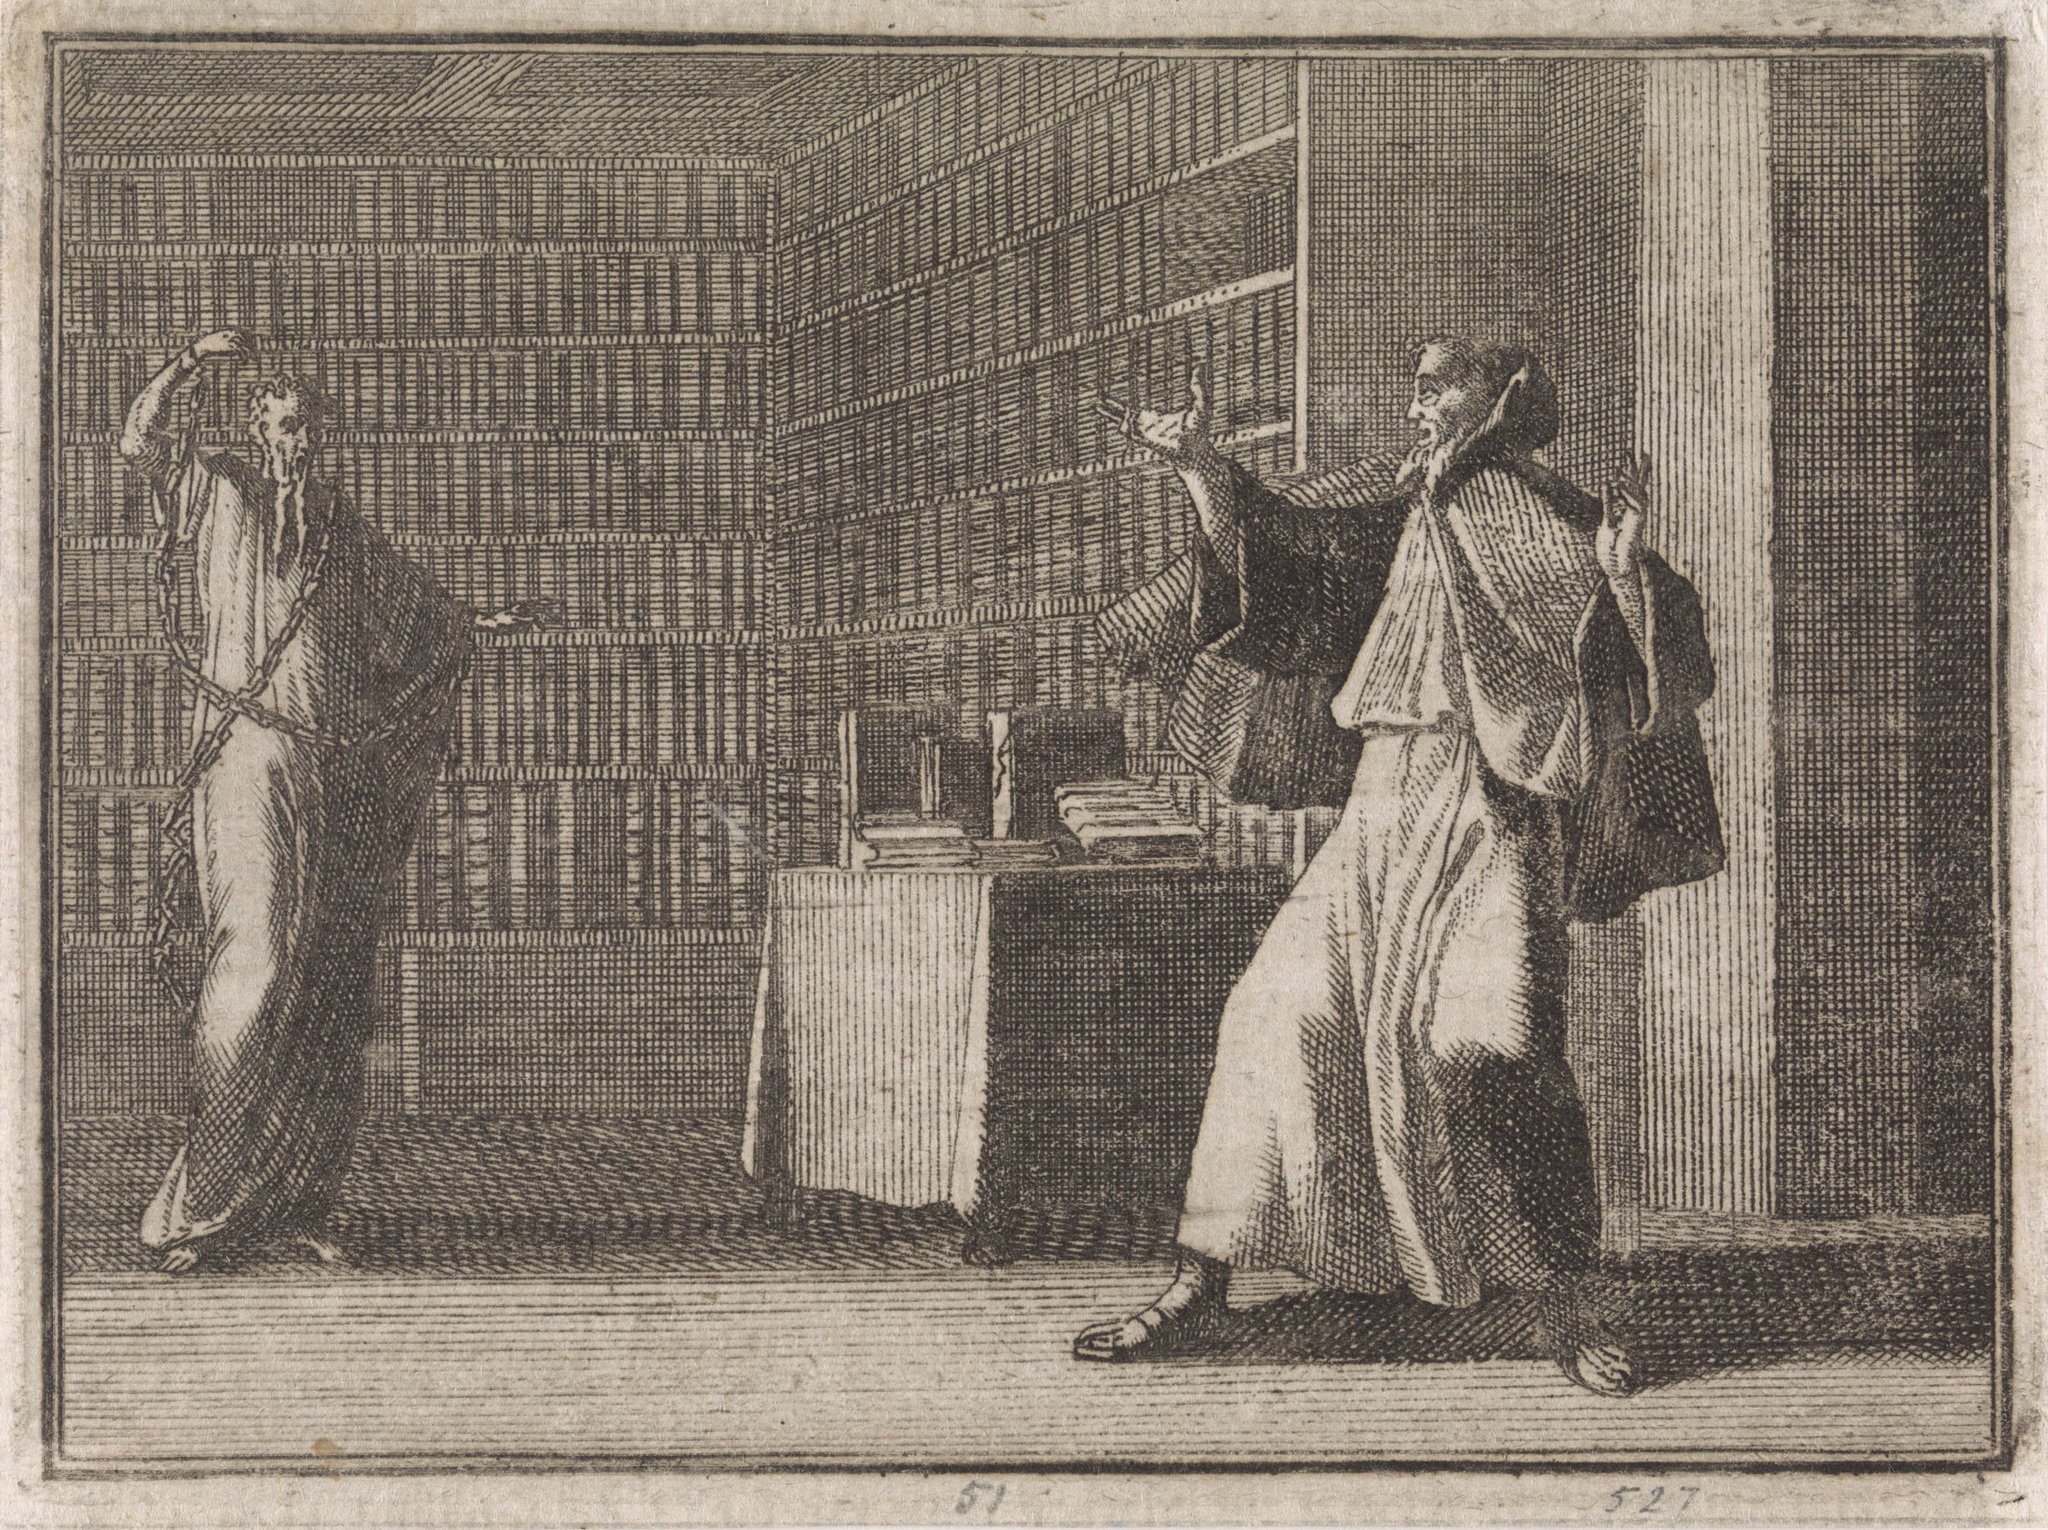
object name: book illustration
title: Monnik schrikt in de bibliotheek van een spook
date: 1704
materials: paper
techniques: etching, letterpress printing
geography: nuremberg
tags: monk(s), friar(s), study; 'studiolo'; library, spirit, ghost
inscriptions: collector's mark: Lugt 2228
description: Illustratie uit: Abraham a Sancta Clara. Heilsames Gemisch Gemasch, das ist: Allerley seltsame und verwunderliche Geschichten (...). Neurenberg: Christoph Weigel, 1704, p. 527.